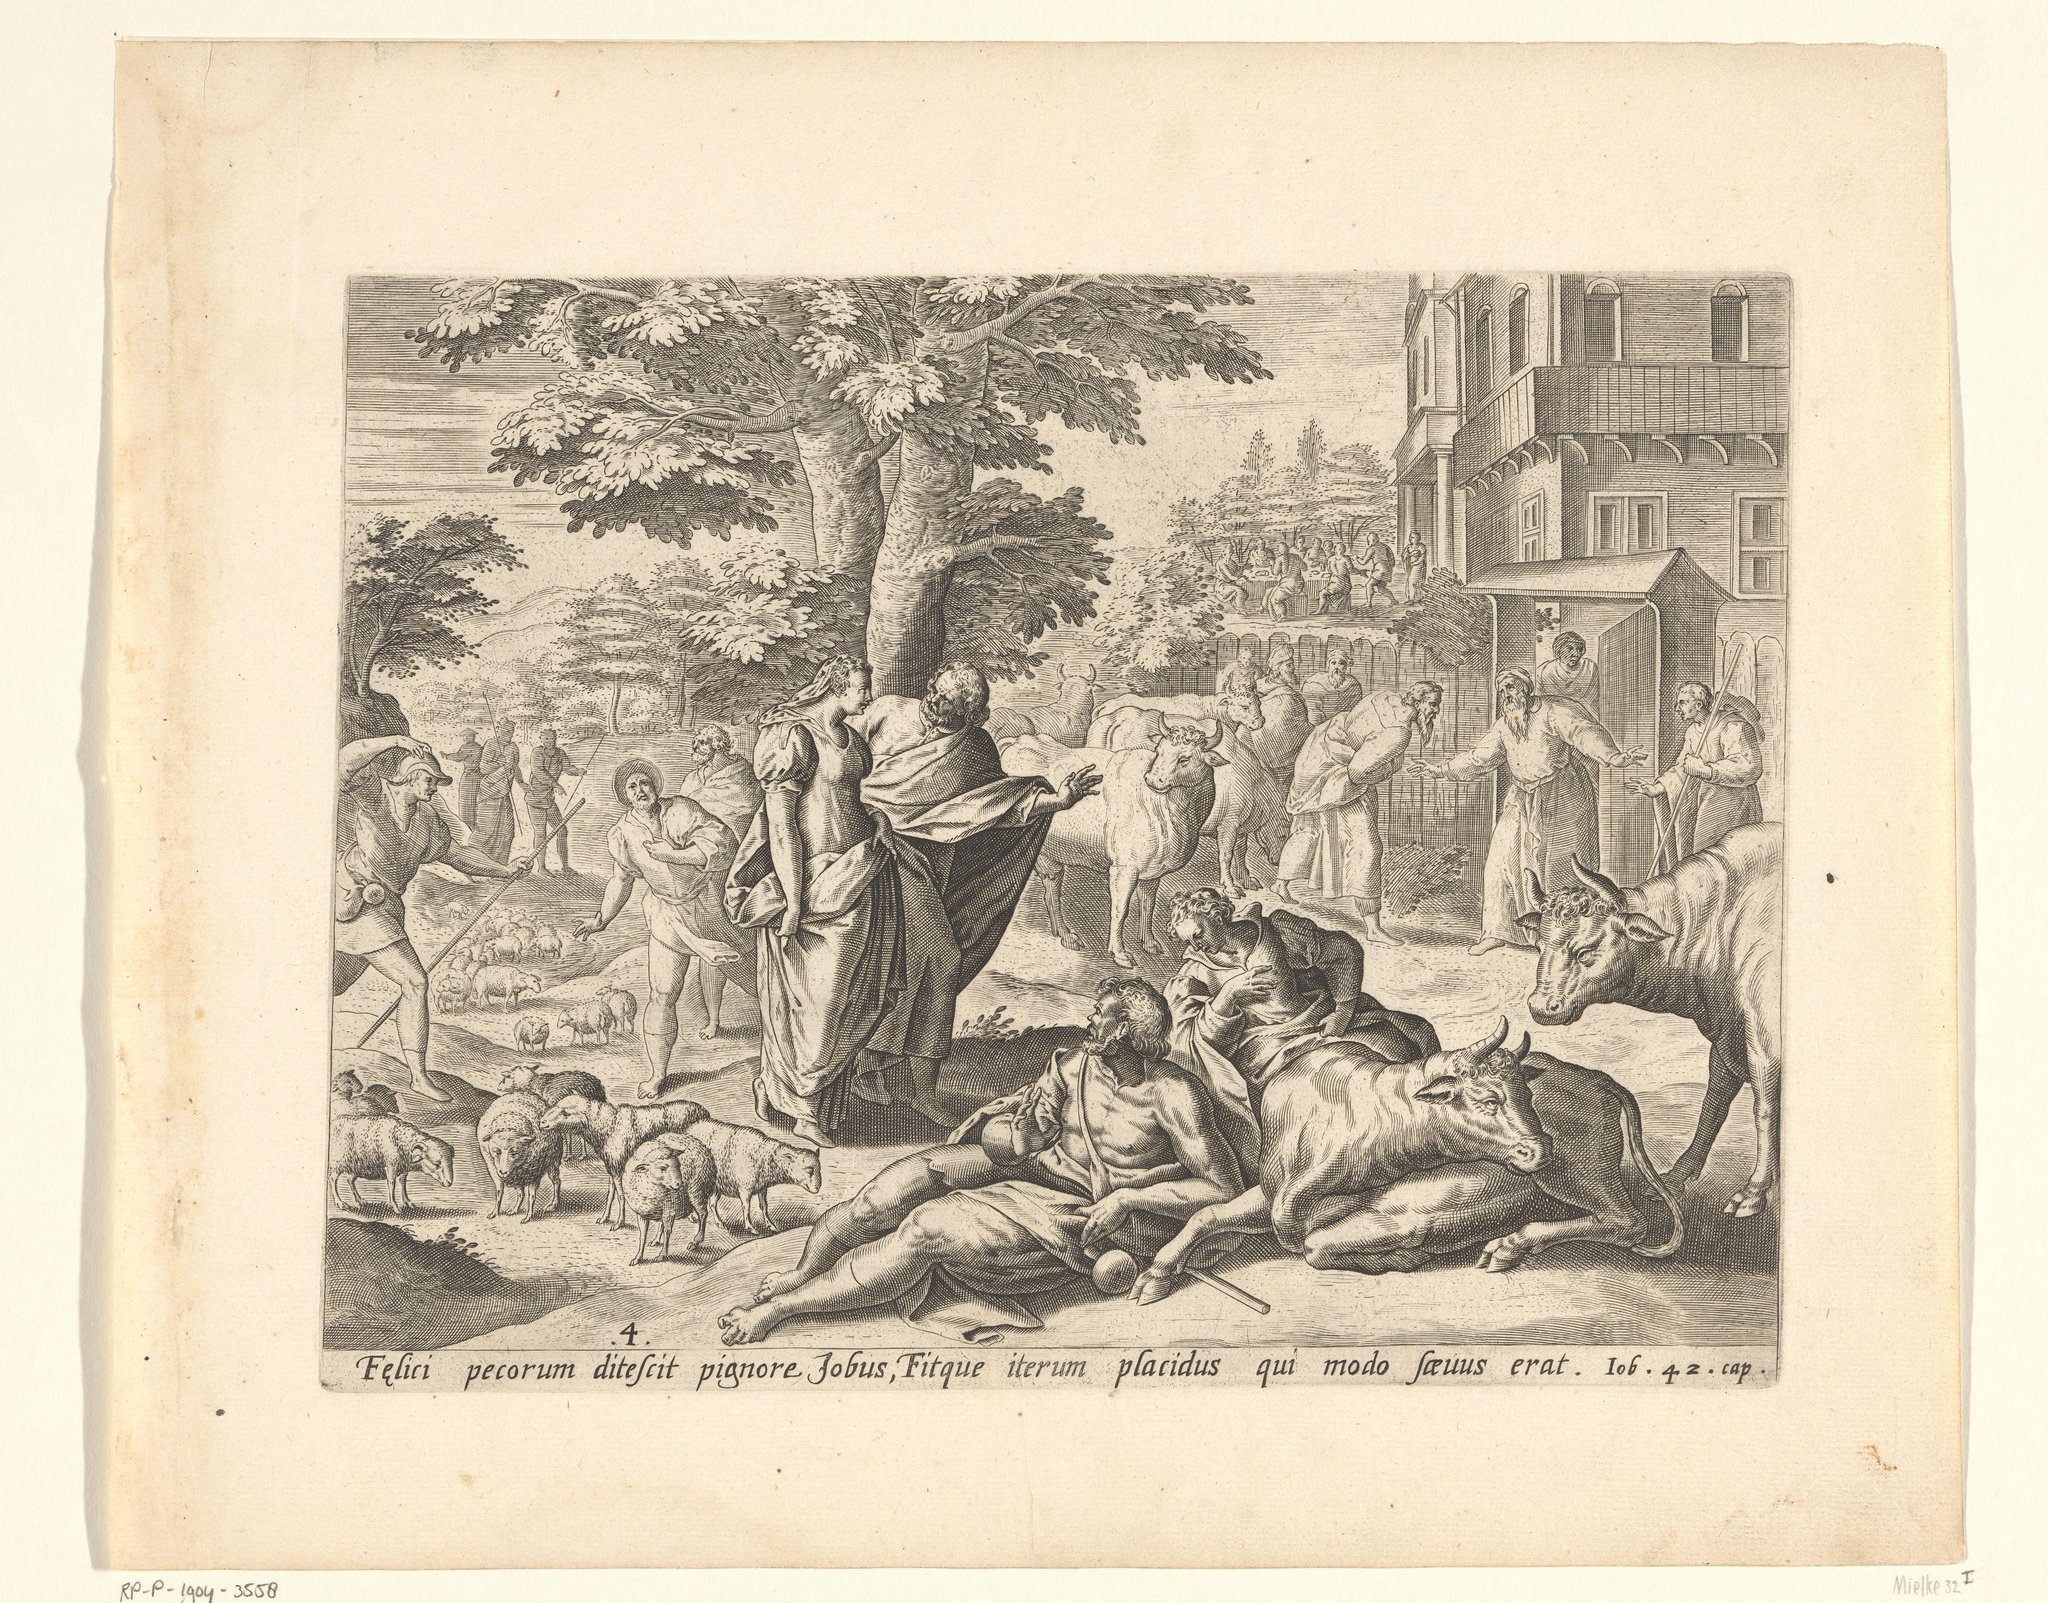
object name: print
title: Geschiedenis van Job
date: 1579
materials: paper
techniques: engraving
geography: antwerp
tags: job's prosperity restored; the last part of his life (job 42:10-17)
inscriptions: collector's mark: Lugt 2228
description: Prent gebruikt in: Thesaurus sacrarum historiaru veteris testamenti, elegatissimis imaginibus expressu excelletissimoru in hac arte viroru opera : nuc primu in luce editus. Antwerpen: Gerard de Jode, 1579. Of prent gebuikt in: Thesaurus sacrarum historiaru[m] veteris (et novi) testame[n]ti, elega[n]tissimis imaginibus expressu[m] excelle[n]tissimoru[m] in hac arte viroru[m] opera : nu[n]c primu[m] in luce[m] editus. Antwerpen: Gerard de Jode, 1585.